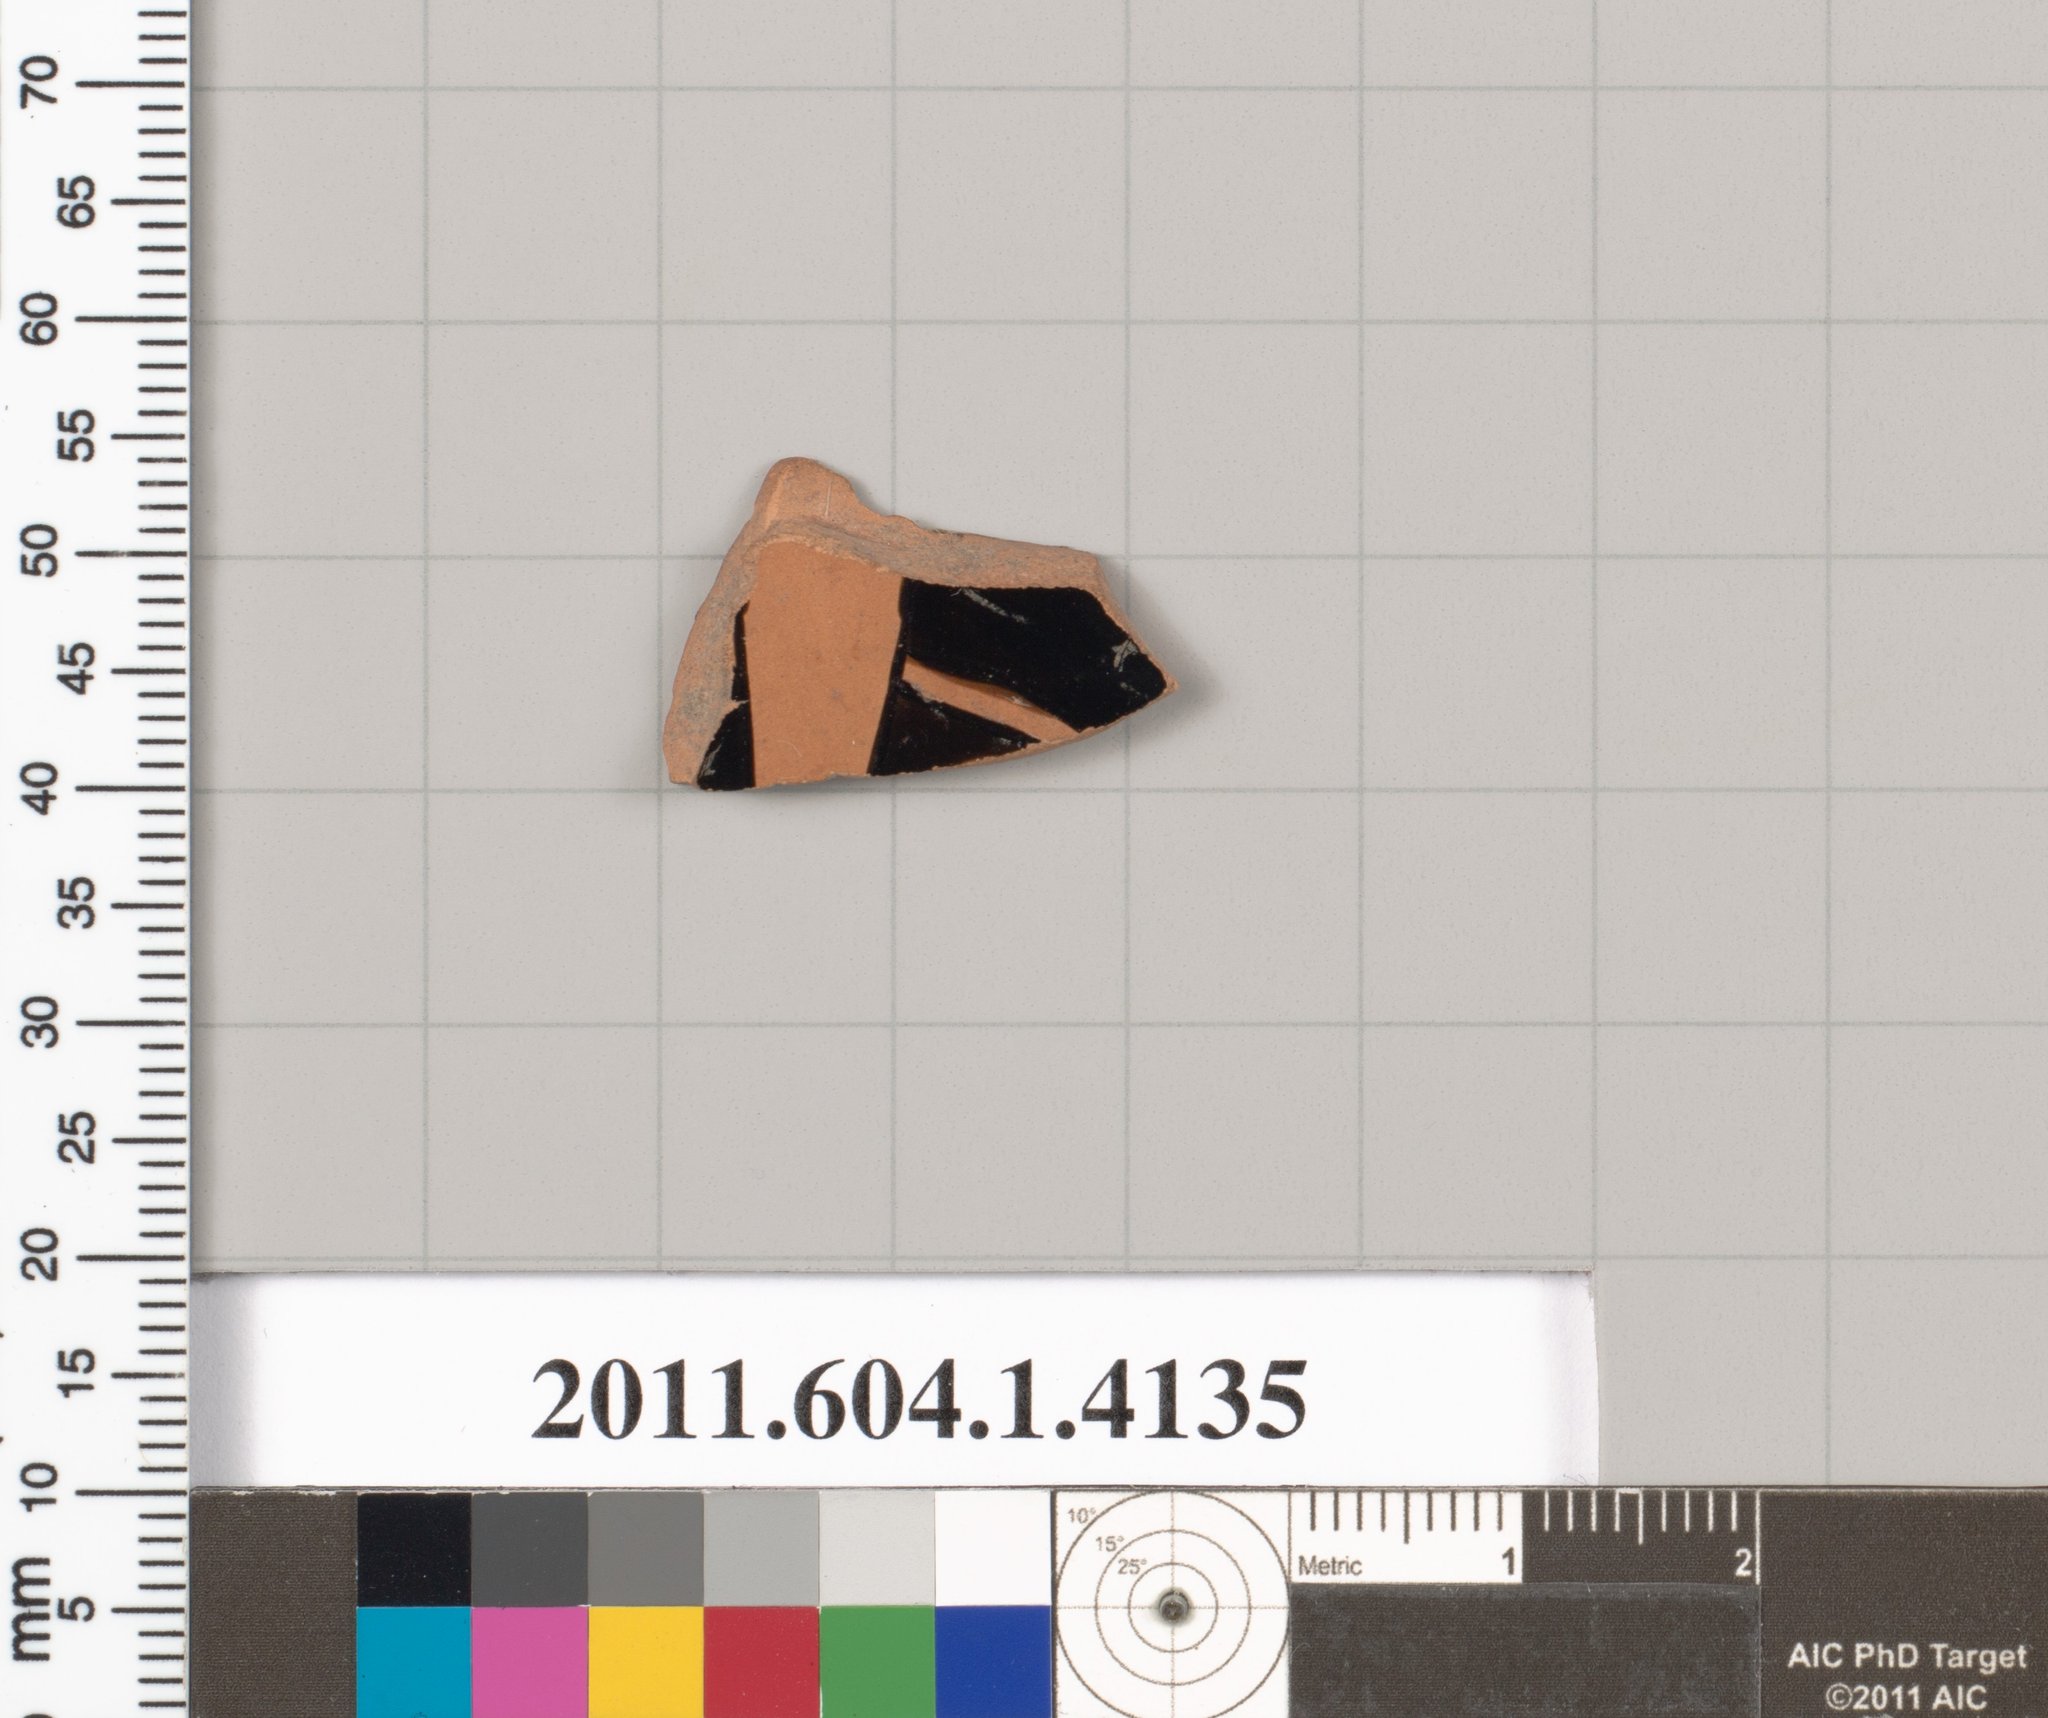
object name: kylix fragment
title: Terracotta fragment of a kylix (drinking cup)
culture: greek, attic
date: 500-480 BCE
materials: terracotta